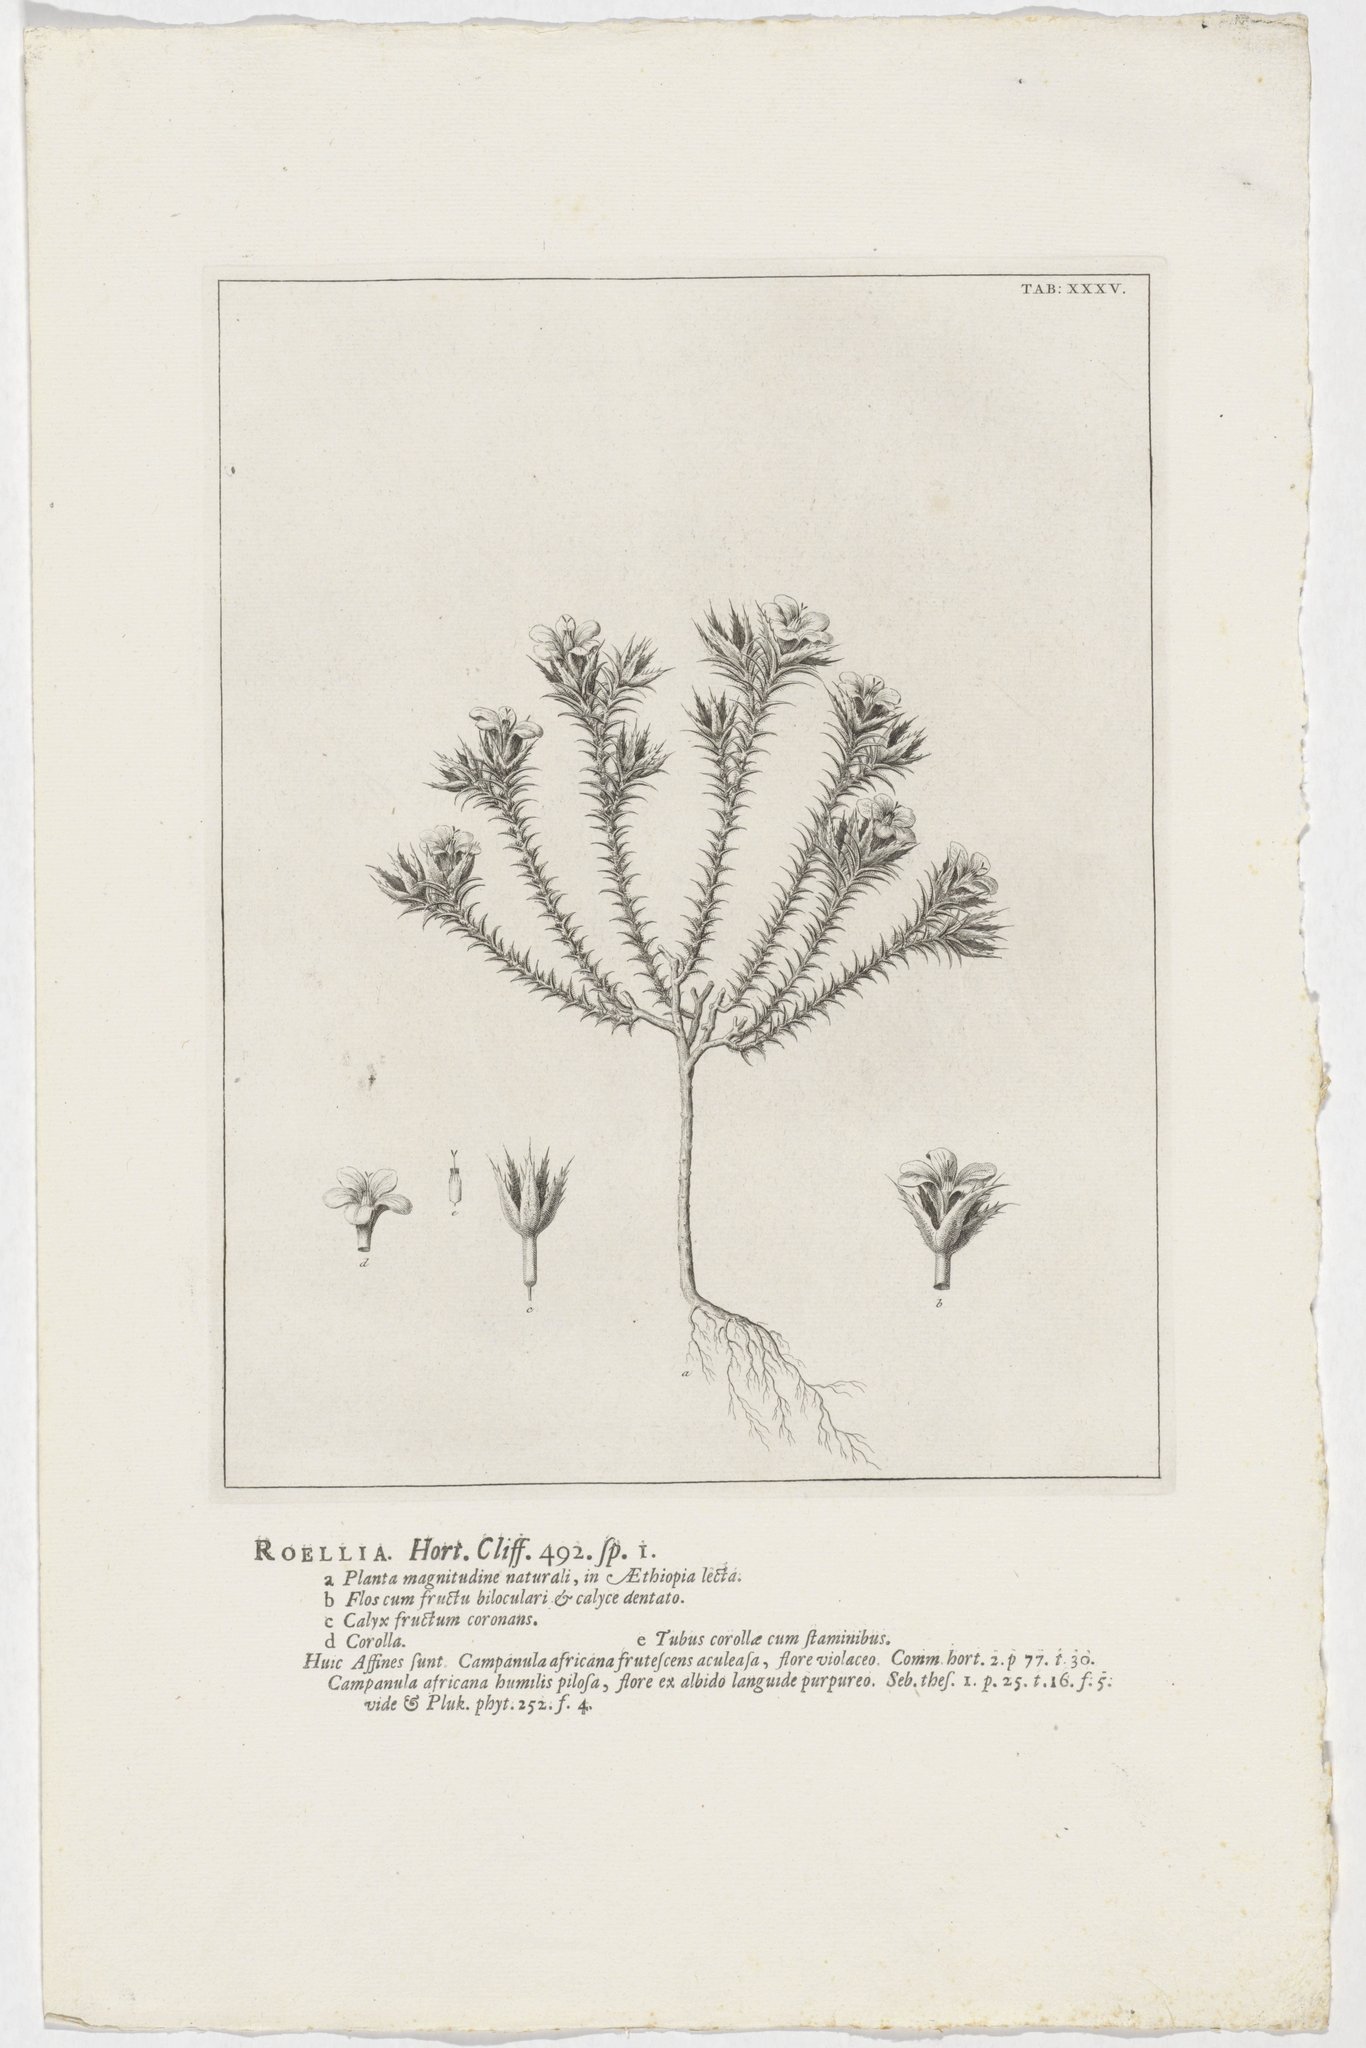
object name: print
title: Roellia. Hort. Cliff. 492. sp. 1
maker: jan wandelaar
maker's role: draughtsman, print maker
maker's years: 1690-1759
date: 1738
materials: paper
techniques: etching, letterpress printing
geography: warmond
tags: flowers, plants and herbs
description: Prent gebruikt als illustratie in: Linnaeus, Carolus. Hortus Cliffortianus plantas exhibens quas in hortis tam vivis quam siccis, Hartecampi in Hollandia, coluit (...) Georgius Clifford. Amsterdam: sine nomen, 1738.